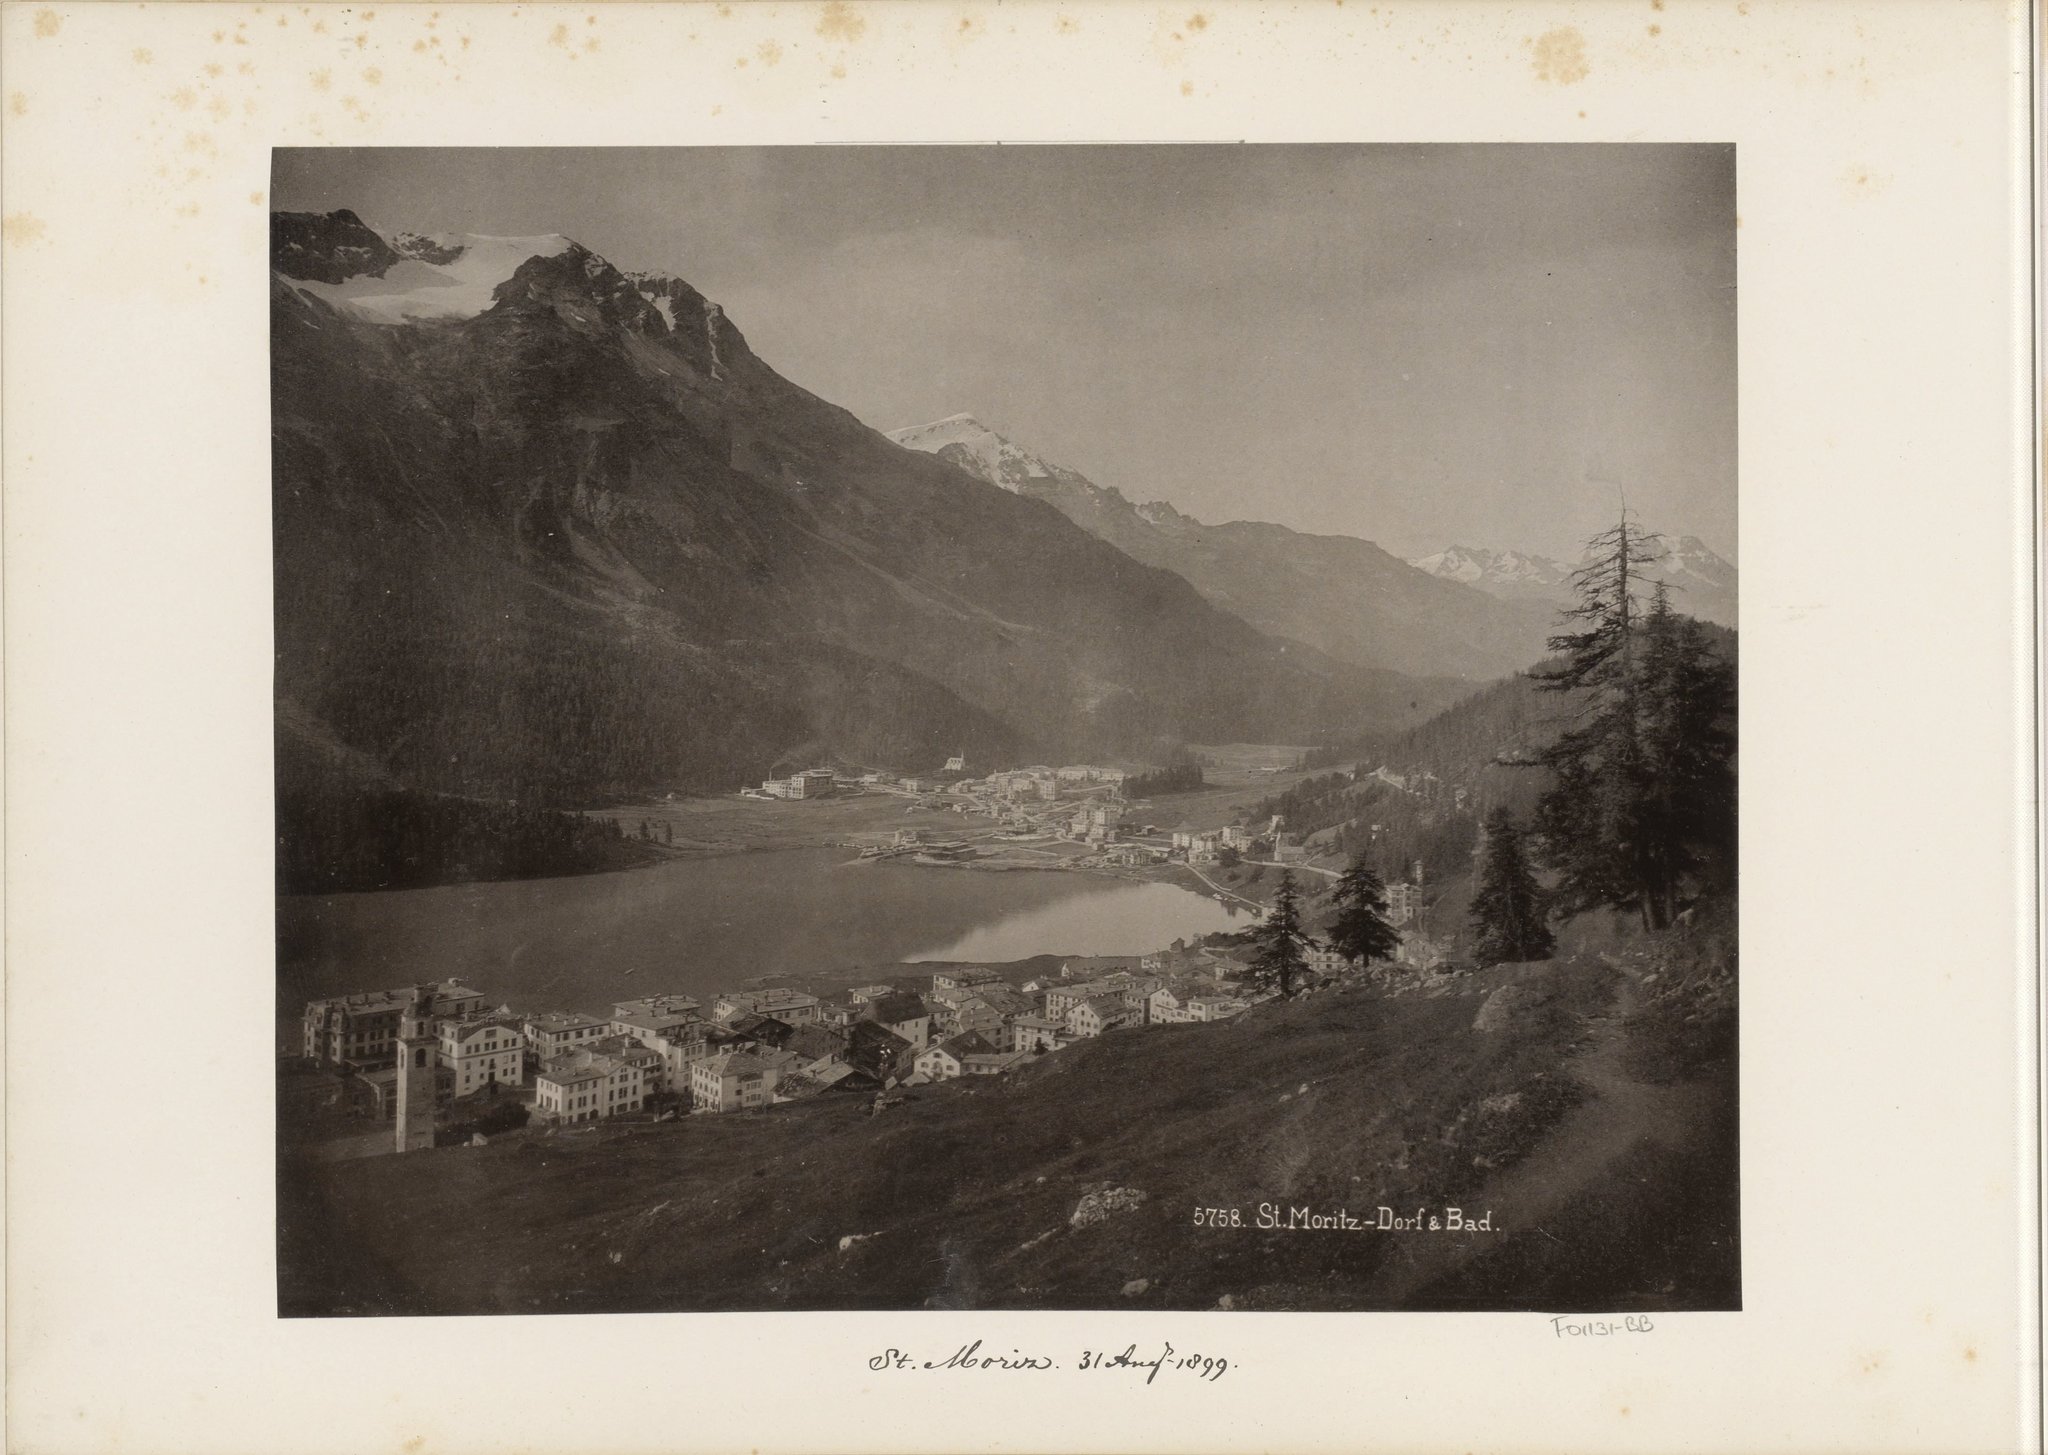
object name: photograph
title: Gezicht op Sankt Moritz en het meer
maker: Anonymous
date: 1880-1899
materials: paper, photographic support, ink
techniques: photograph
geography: sankt moritz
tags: prospect of village, silhouette of village, lake, mountains (+ landscape with figures, staffage)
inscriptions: number: ‘5758’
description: Onderdeel van Reisalbum met bezienswaardigheden in Duitsland, Oostenrijk, Zwitserland, Luxemburg en België.